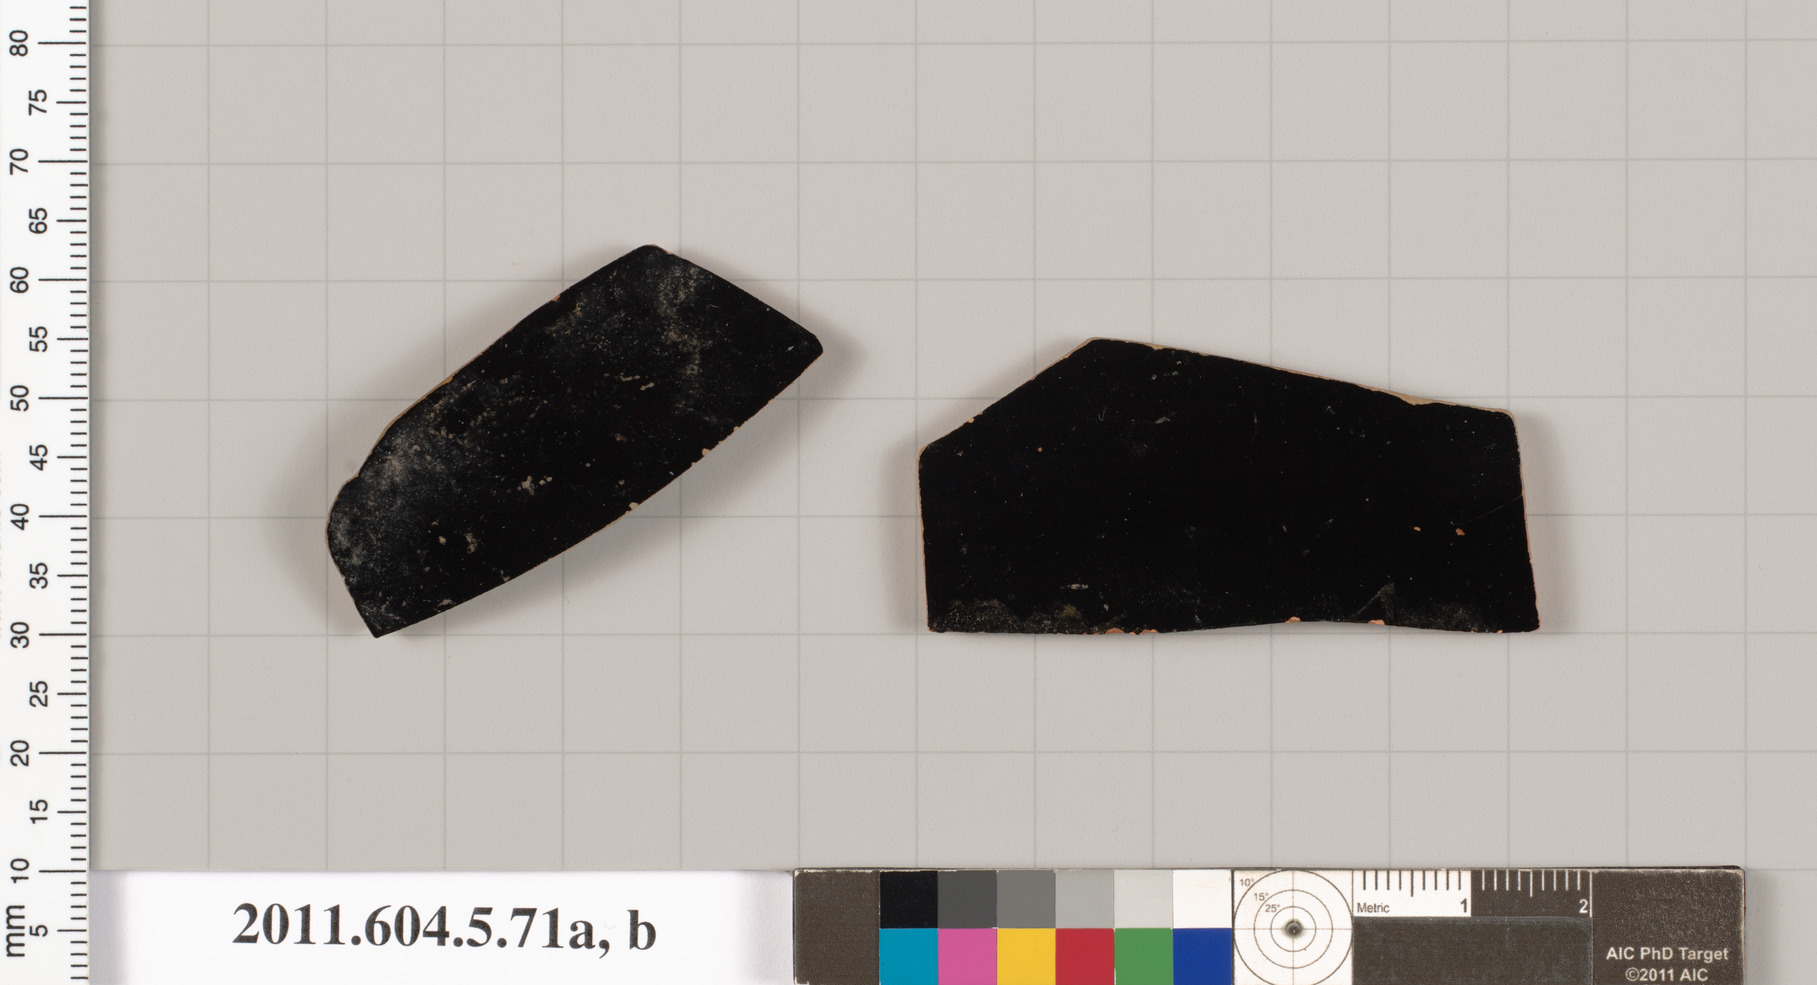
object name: kylix fragment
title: Terracotta fragments of a kylix (drinking cup)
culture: greek, attic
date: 510-470 BCE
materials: terracotta